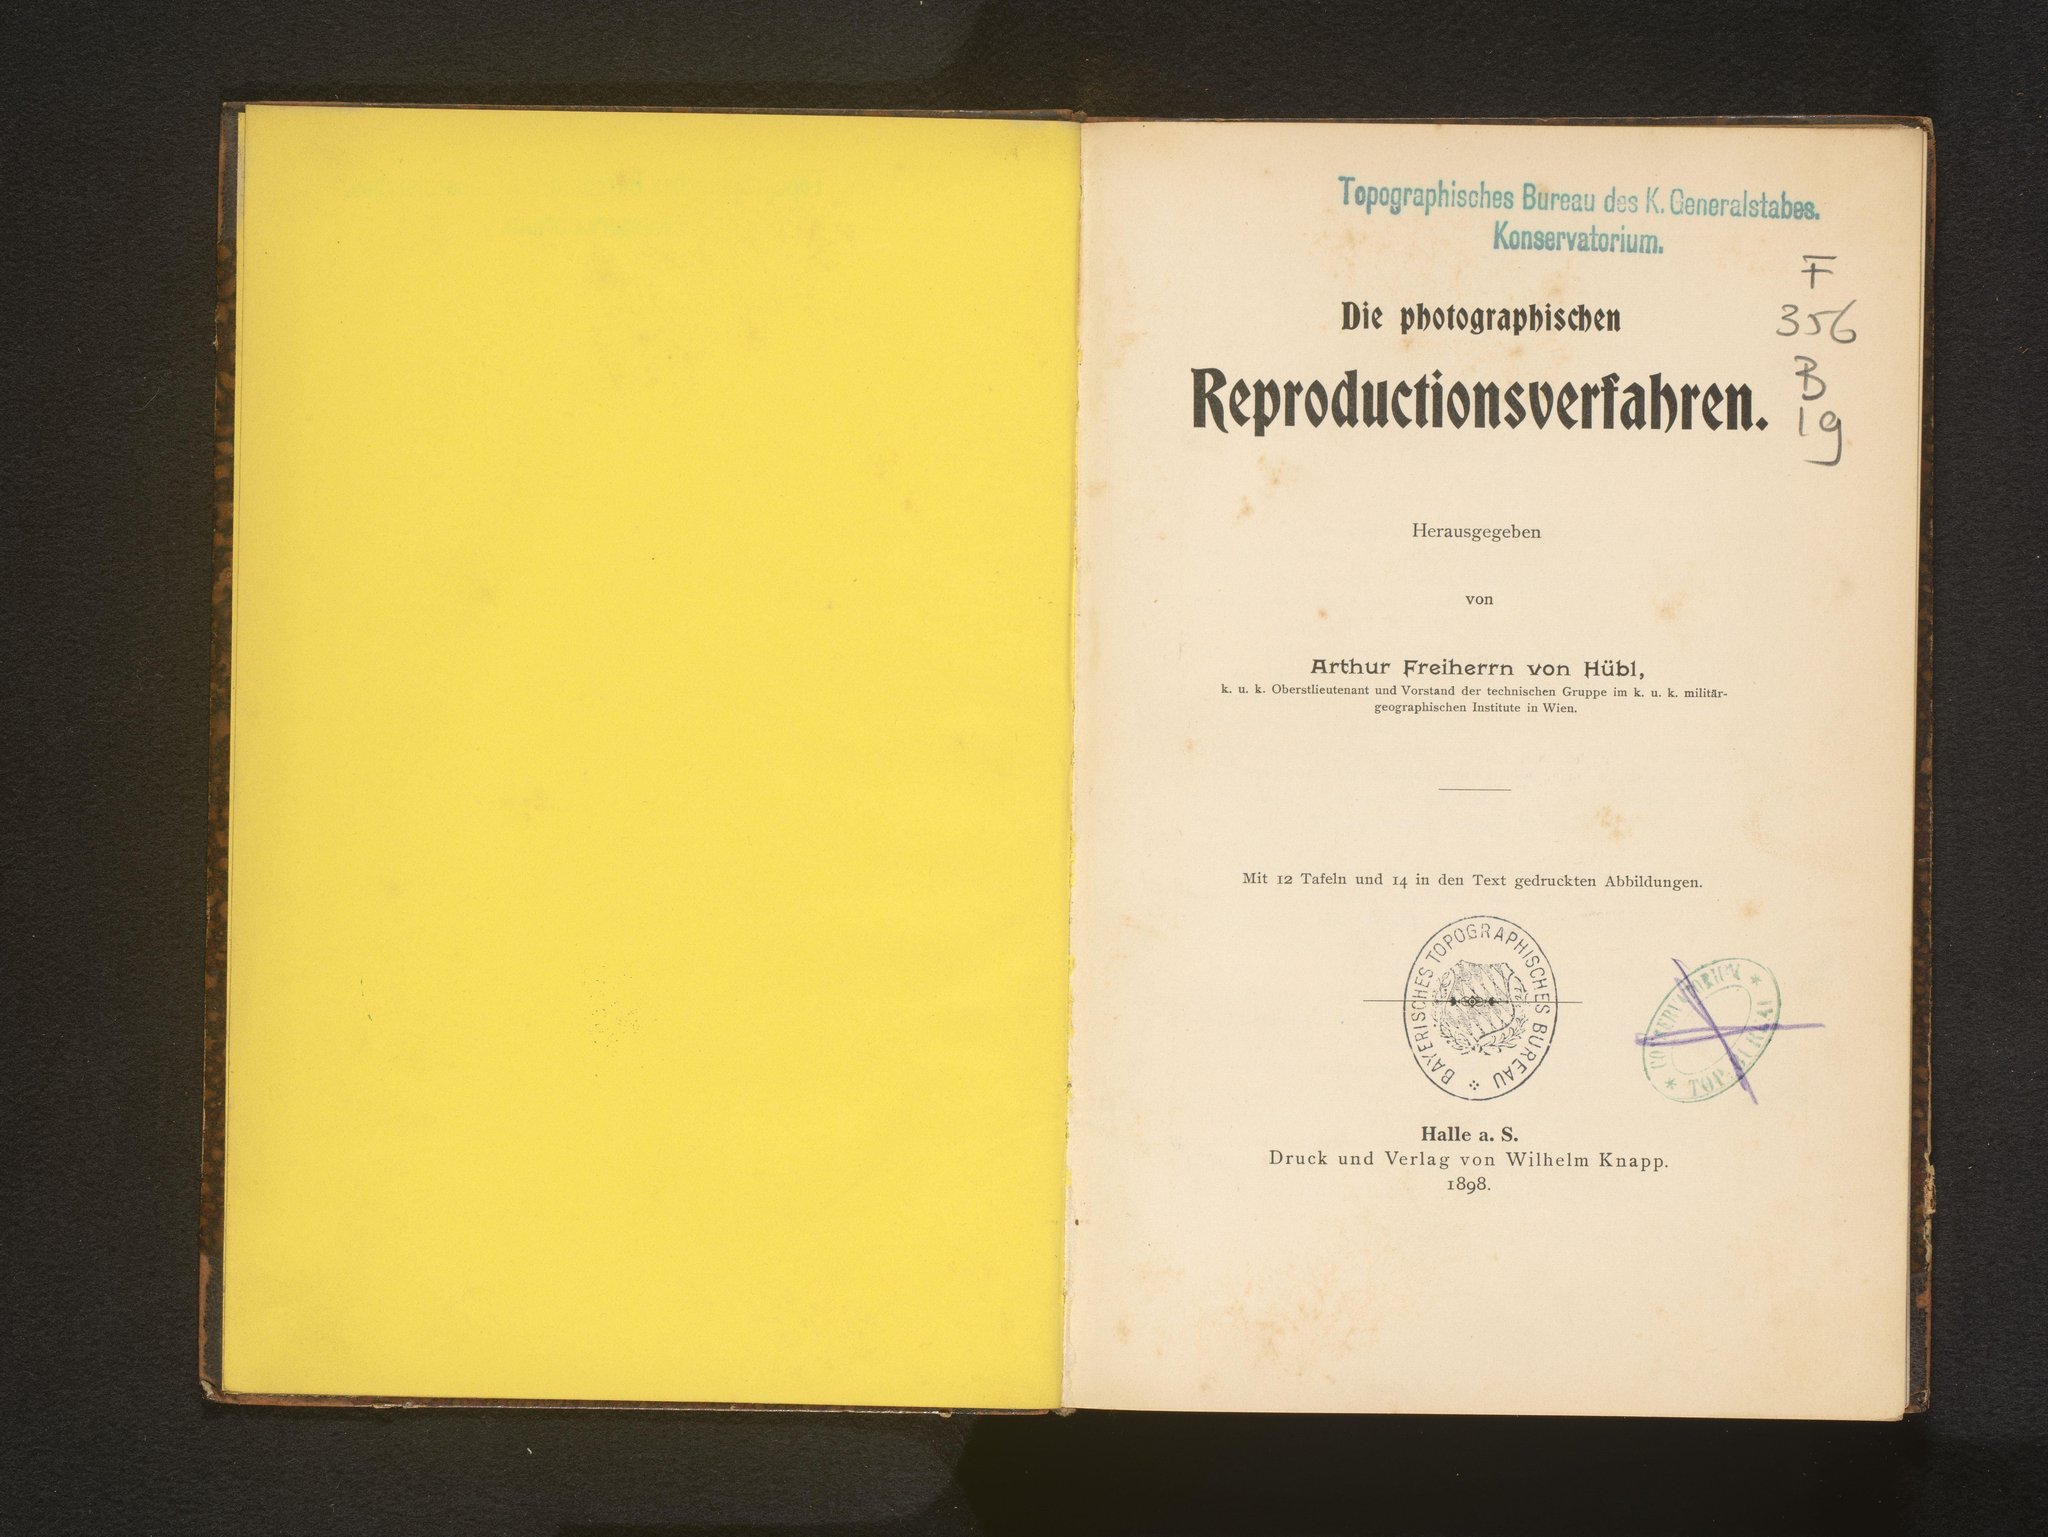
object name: book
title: Die photographischen Reproductionsverfahren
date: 1898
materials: paper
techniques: photograph, photoaquatint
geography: halle an der saale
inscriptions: name: ‘Topographisches Bureau des K. Generalstabes. Konservatorium.’